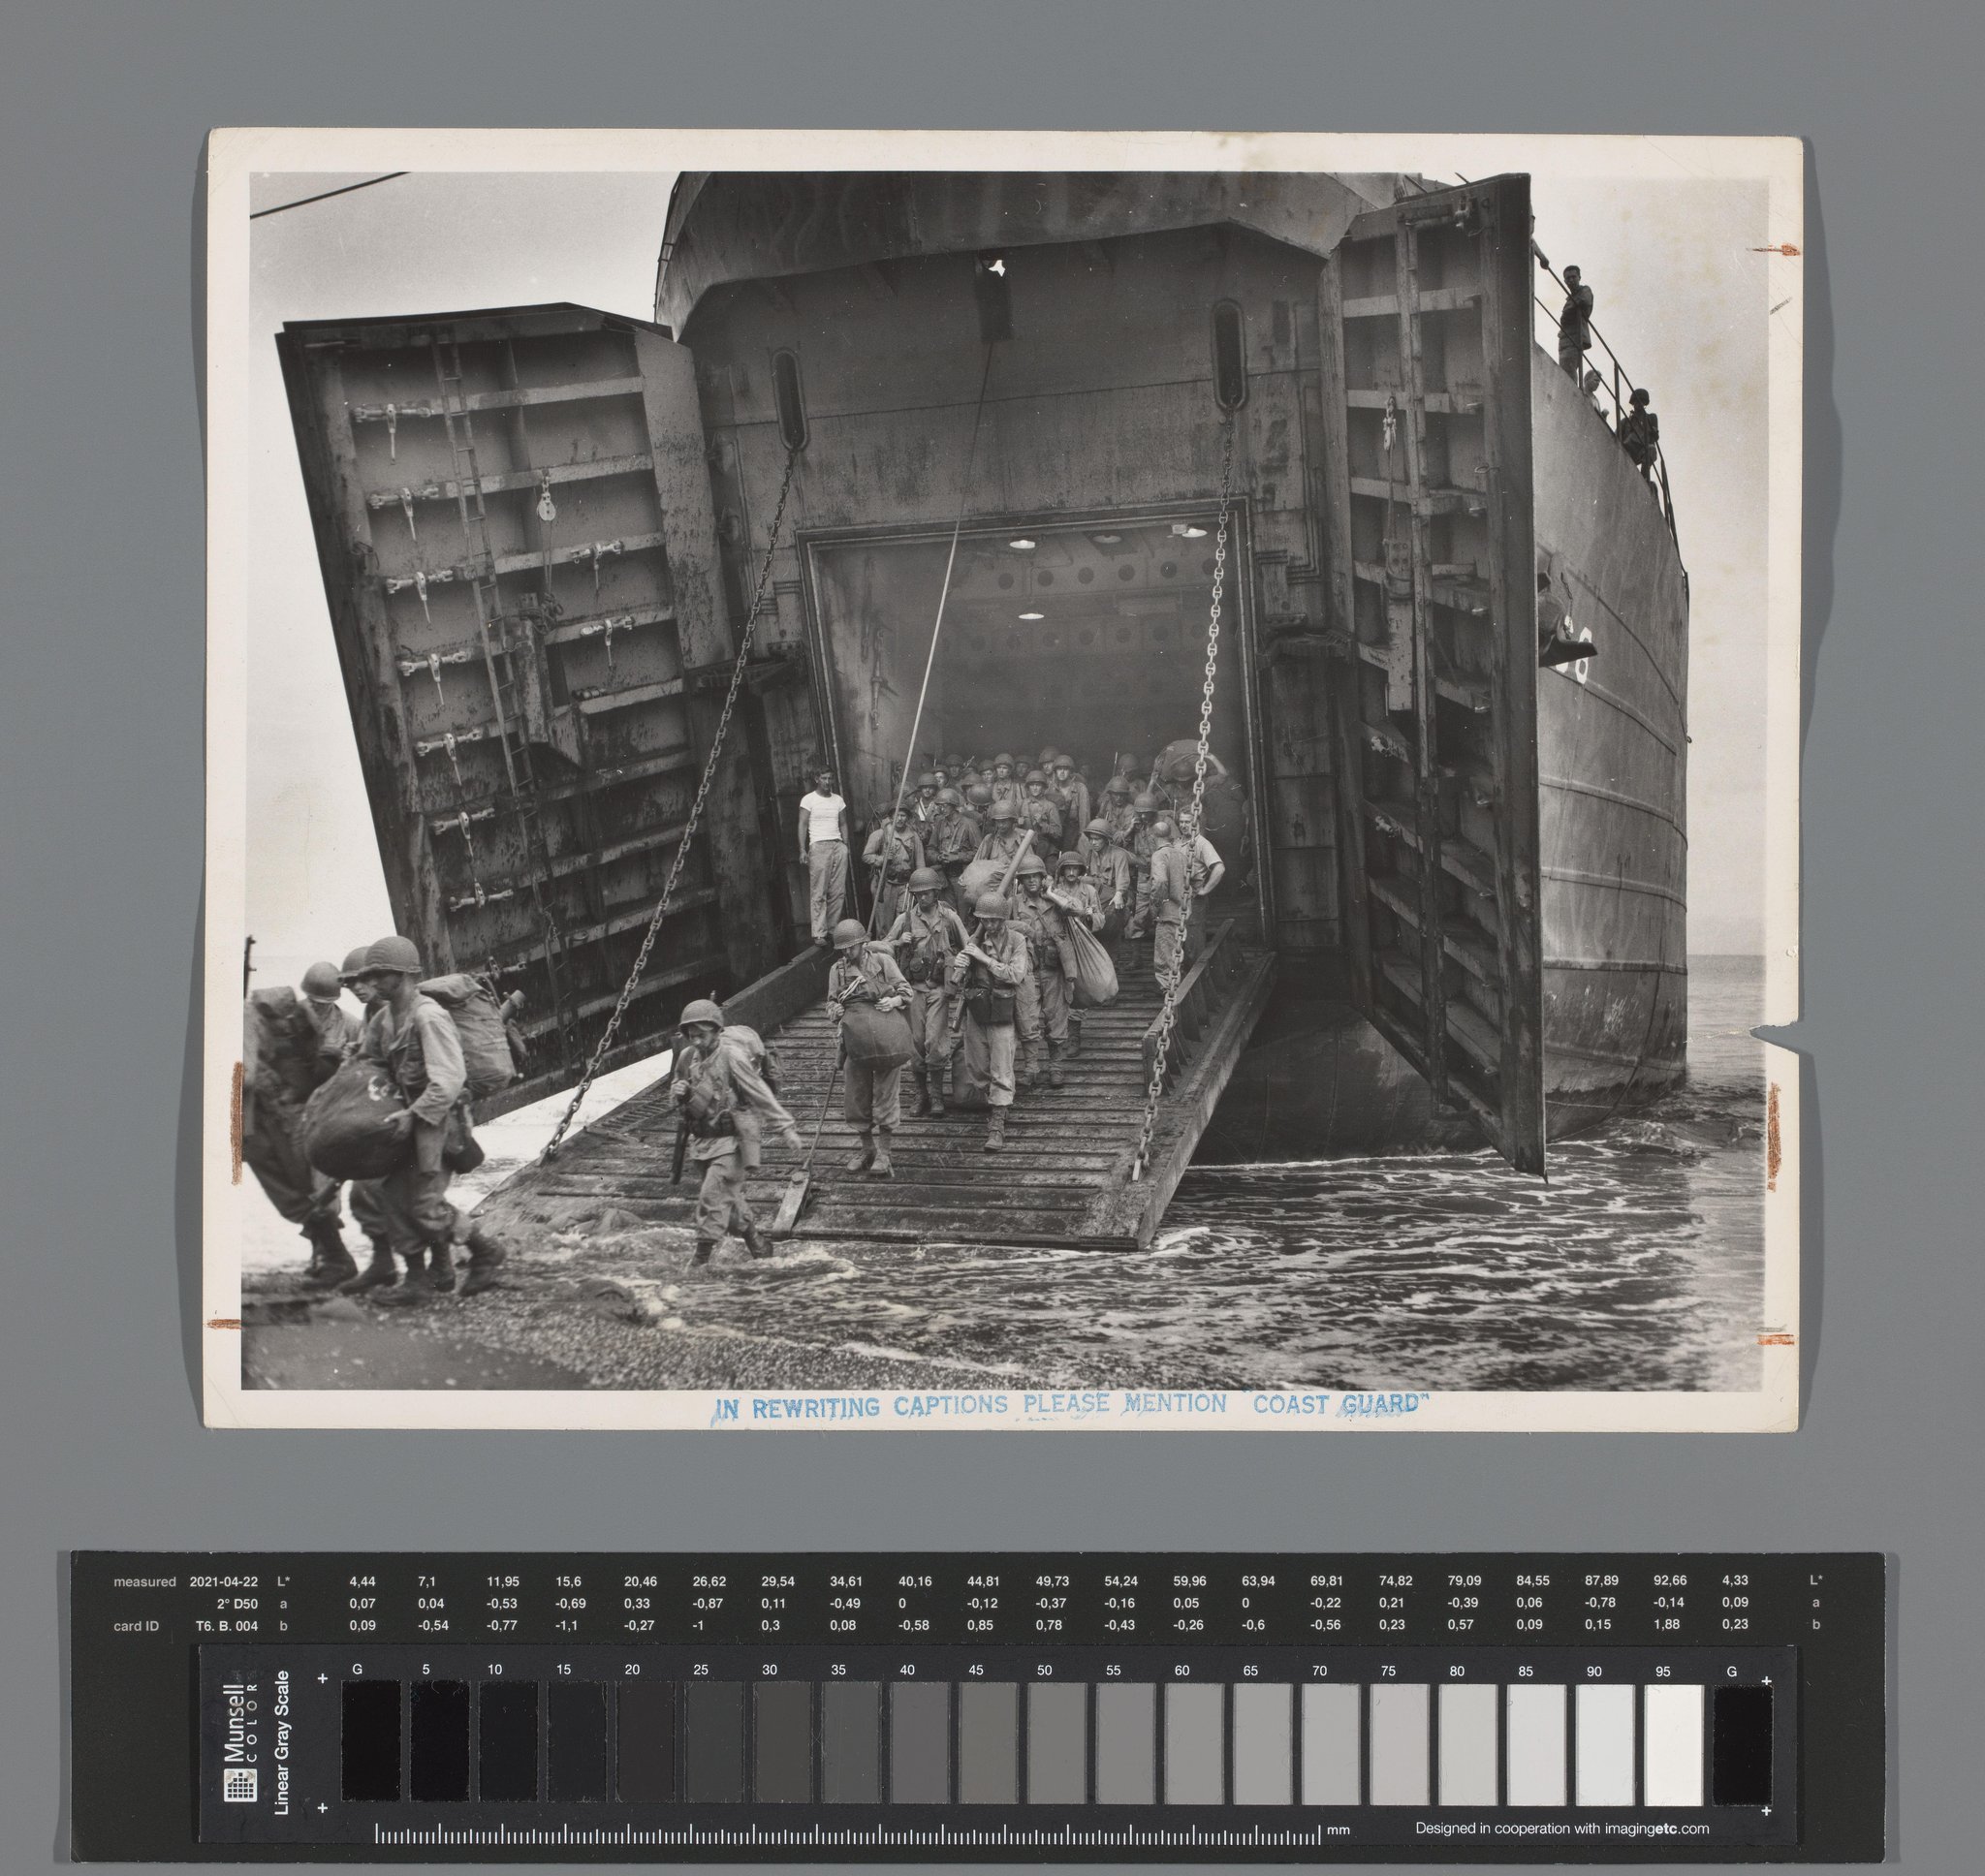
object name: photograph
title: Amerikaanse troepen verlaten een schip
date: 1944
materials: photographic support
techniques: gelatin silver print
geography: great ocean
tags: grote oceaan, tweede wereldoorlog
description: Amerikaanse troepen verlaten 'Navy Ship landing Craft' op een door Japanners bezet eiland in de Pacific.